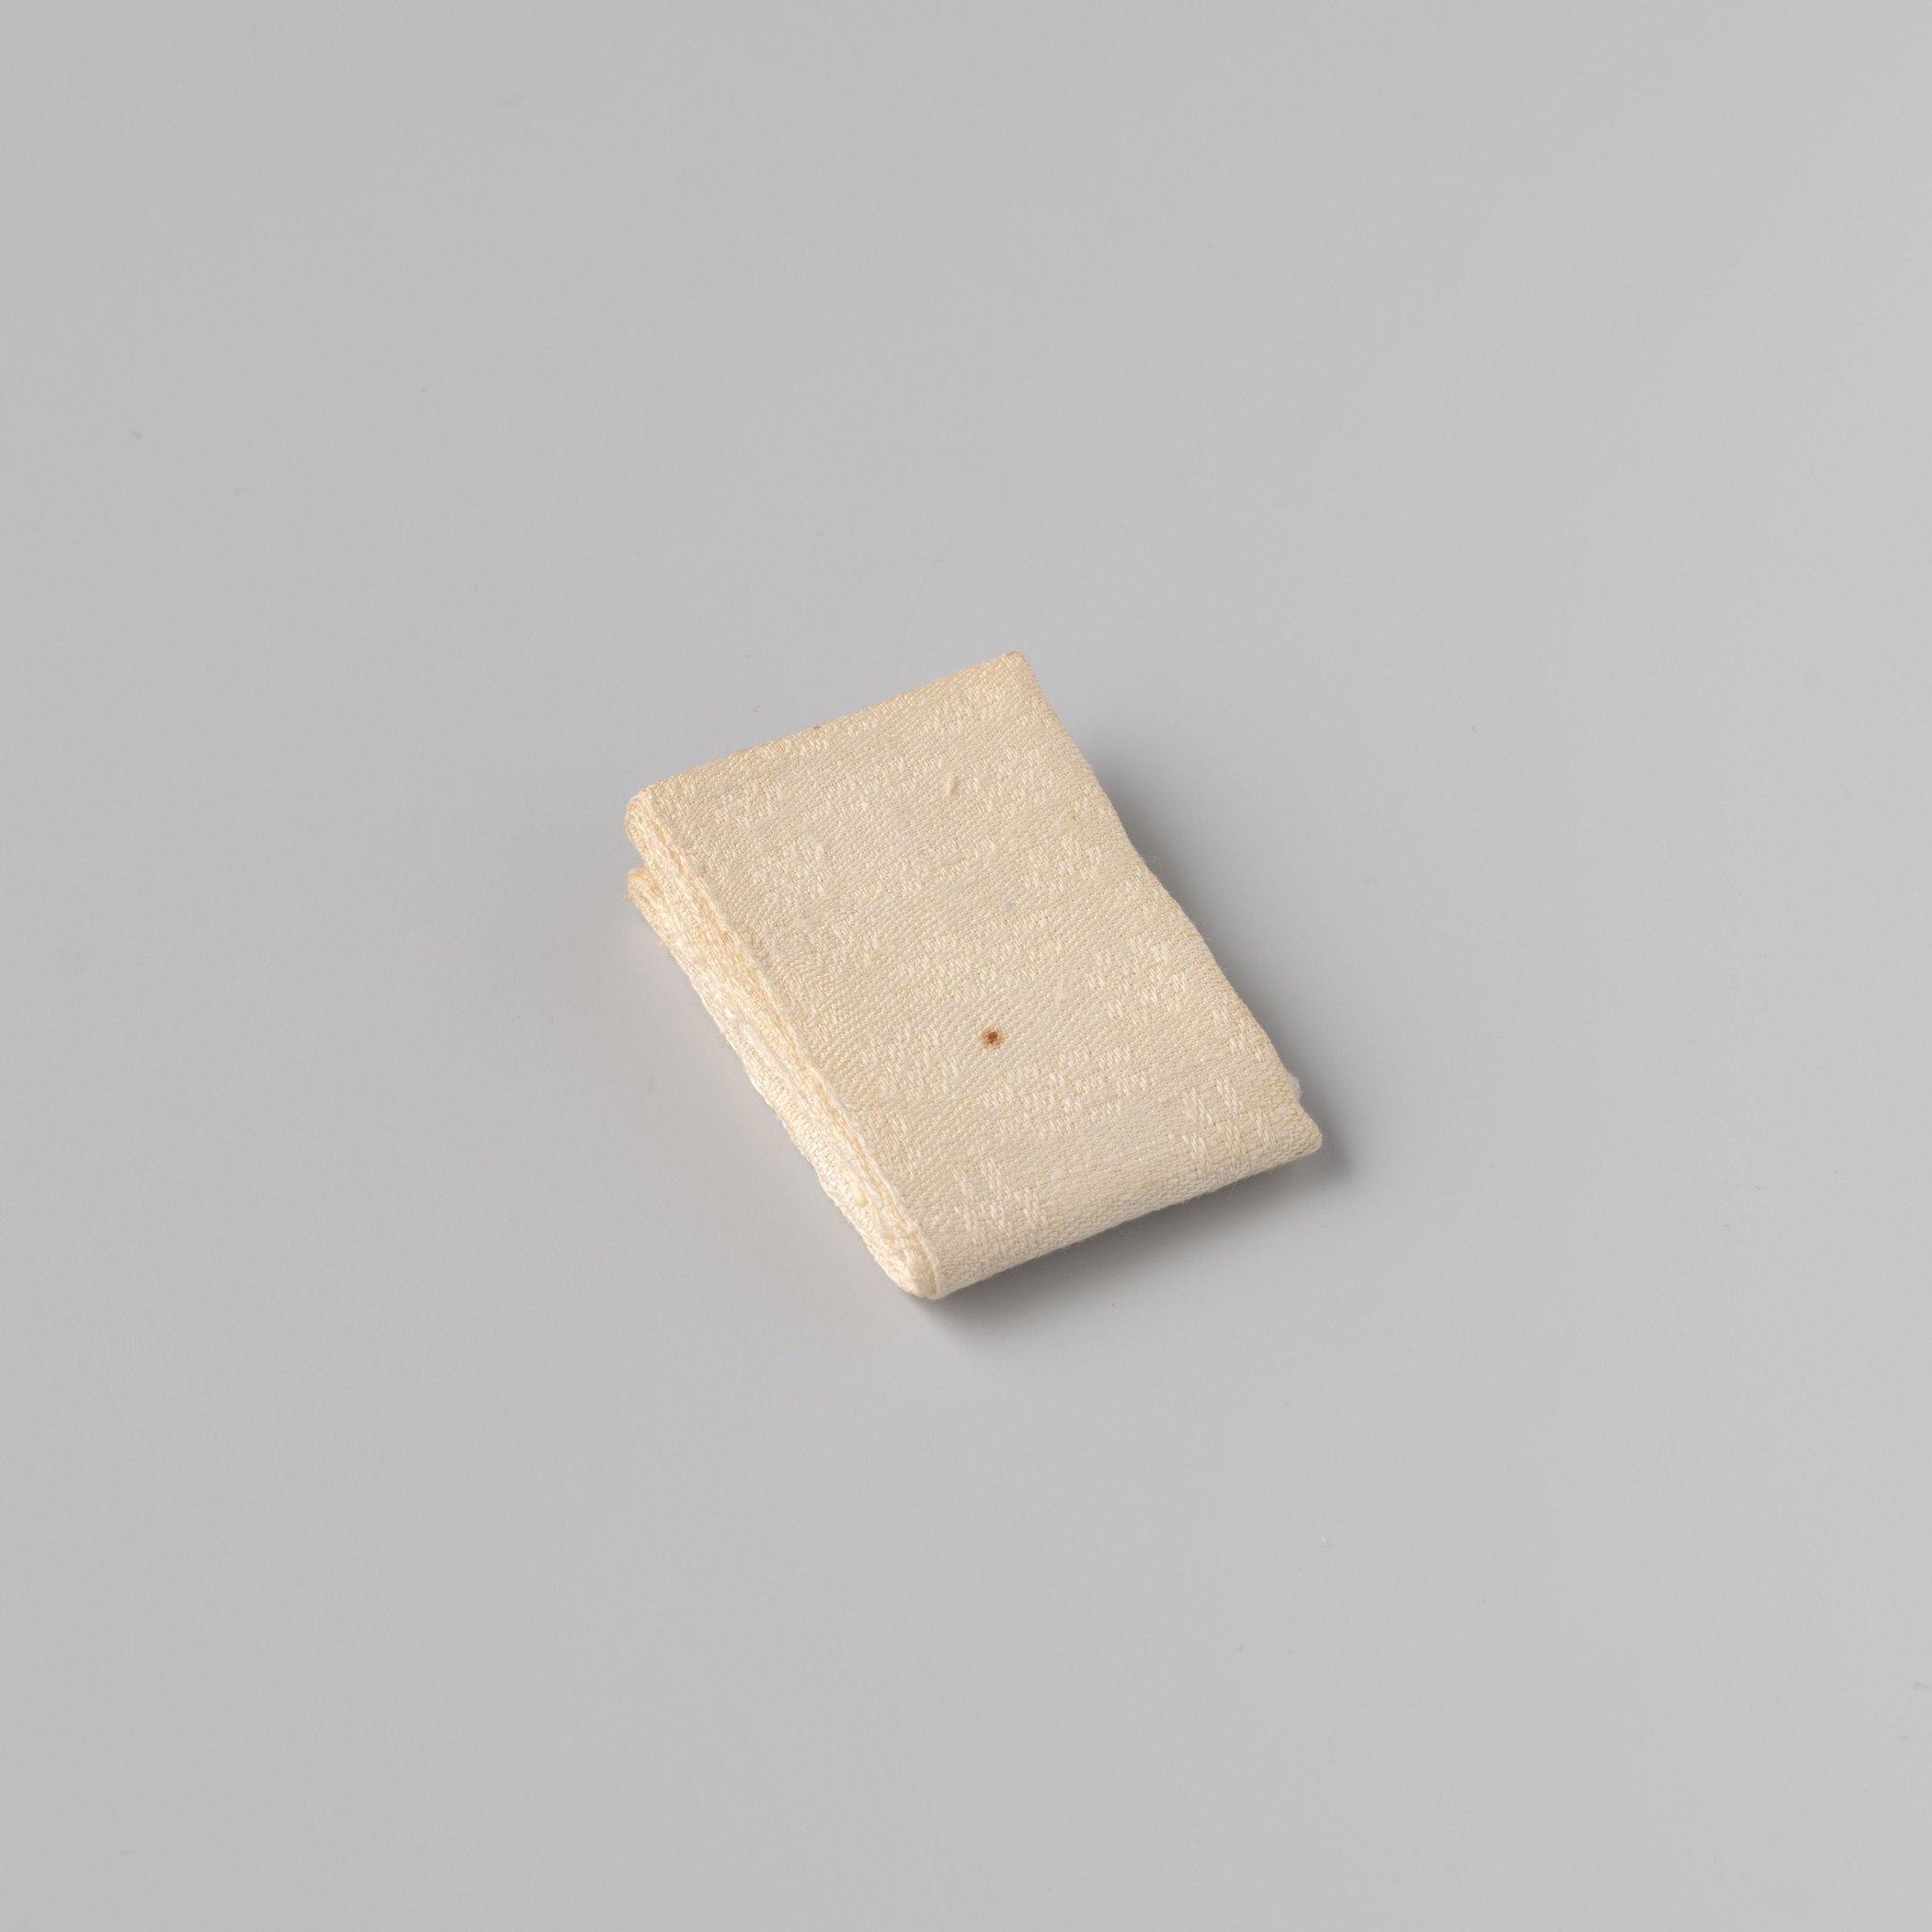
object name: napkin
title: Linnen servet van damastweefsel met pellenpatroon (motief III), geen zomen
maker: Anonymous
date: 1690-1710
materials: linen